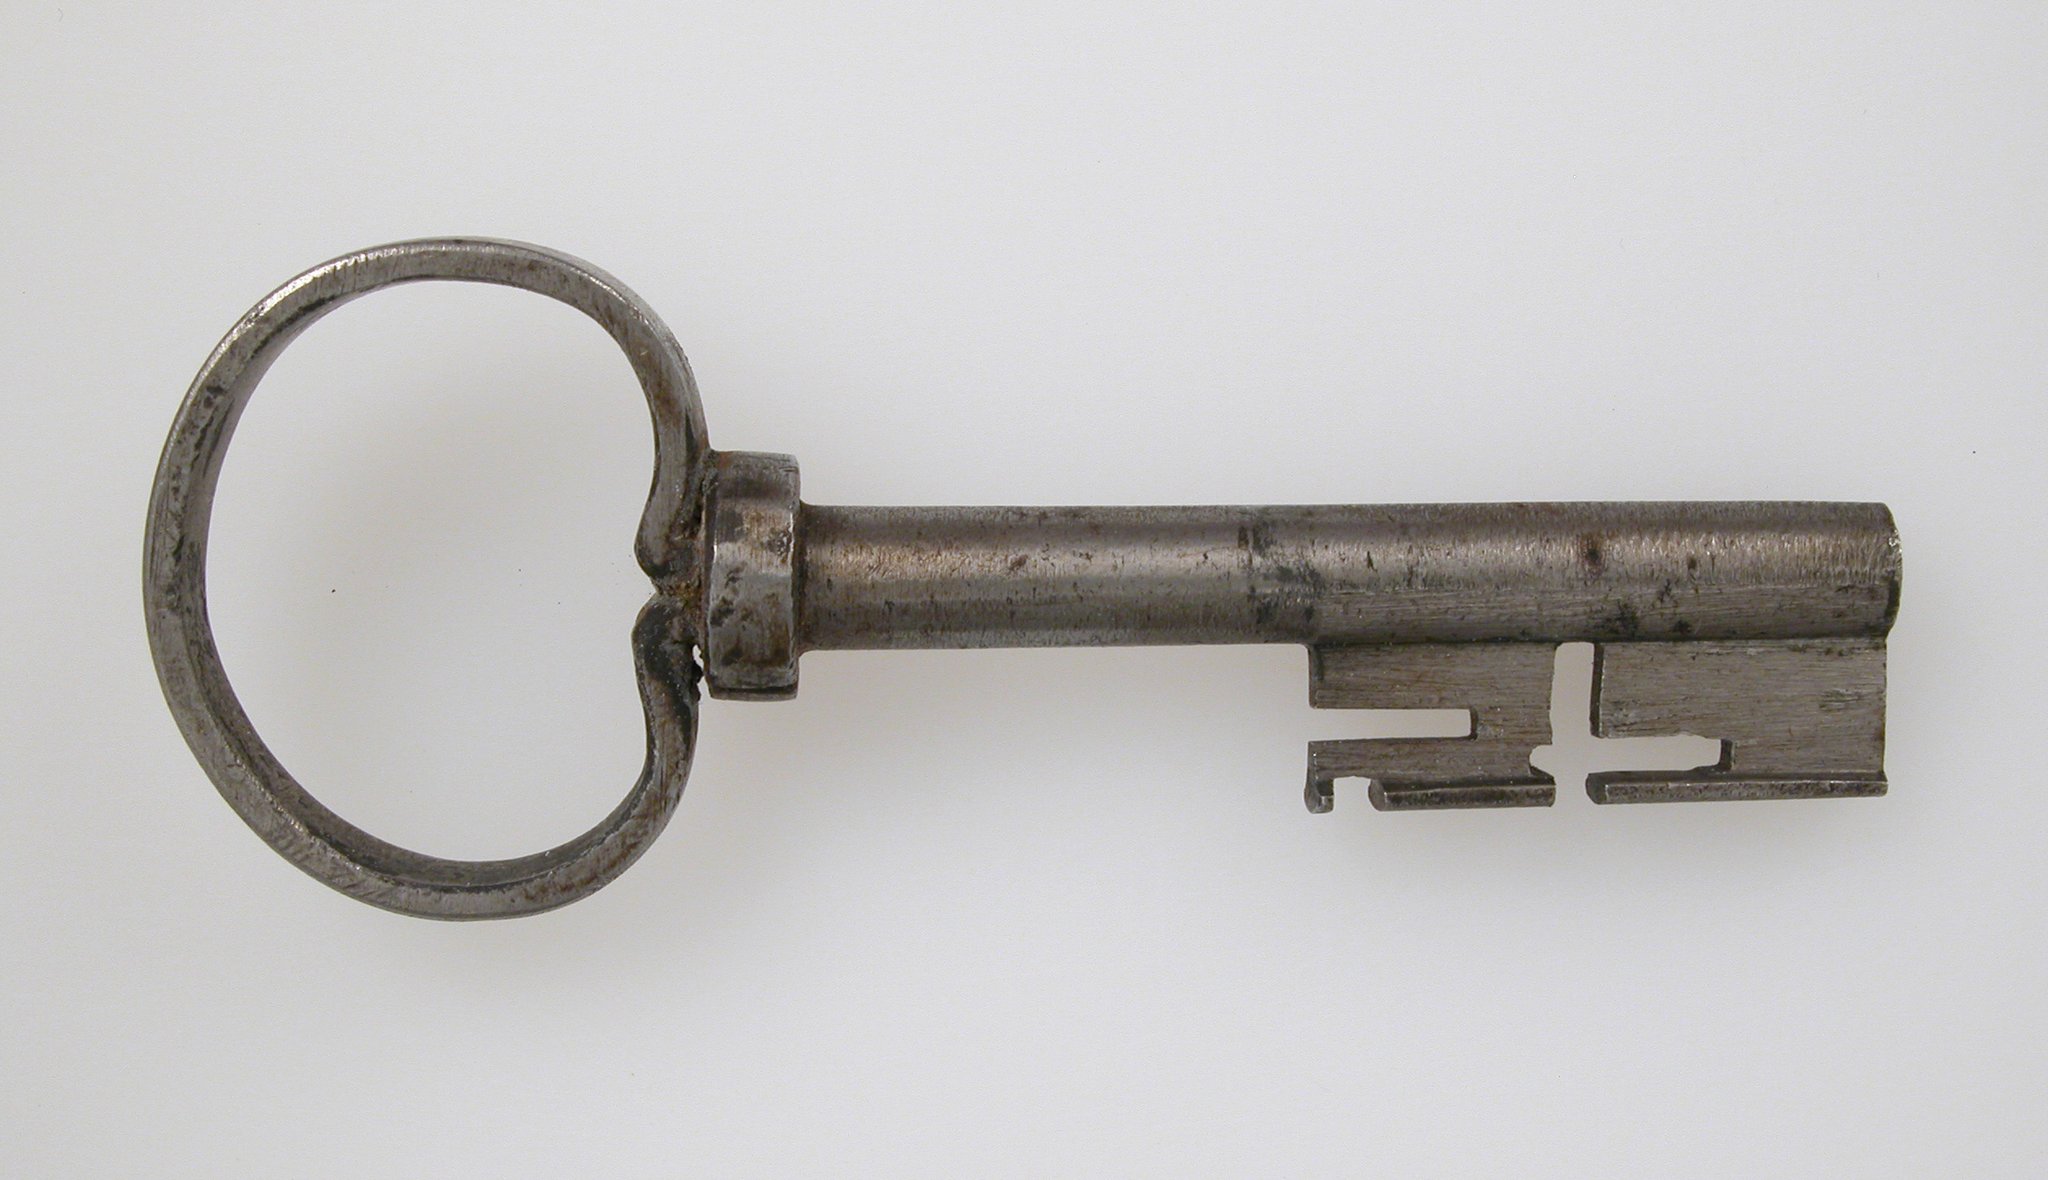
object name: key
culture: german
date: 1401-1500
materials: iron